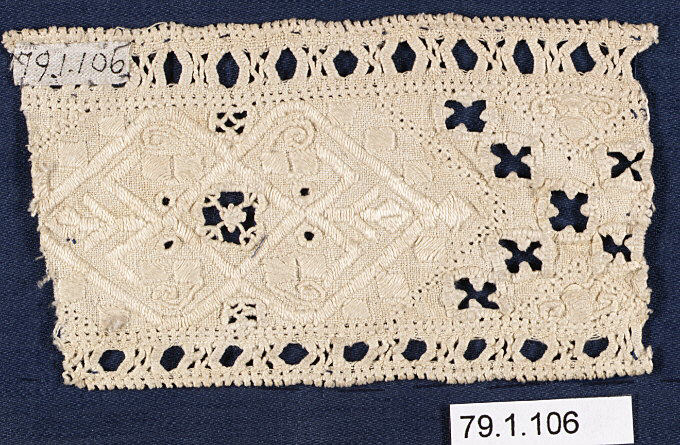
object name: fragment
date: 1501-1600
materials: linen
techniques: embroidery